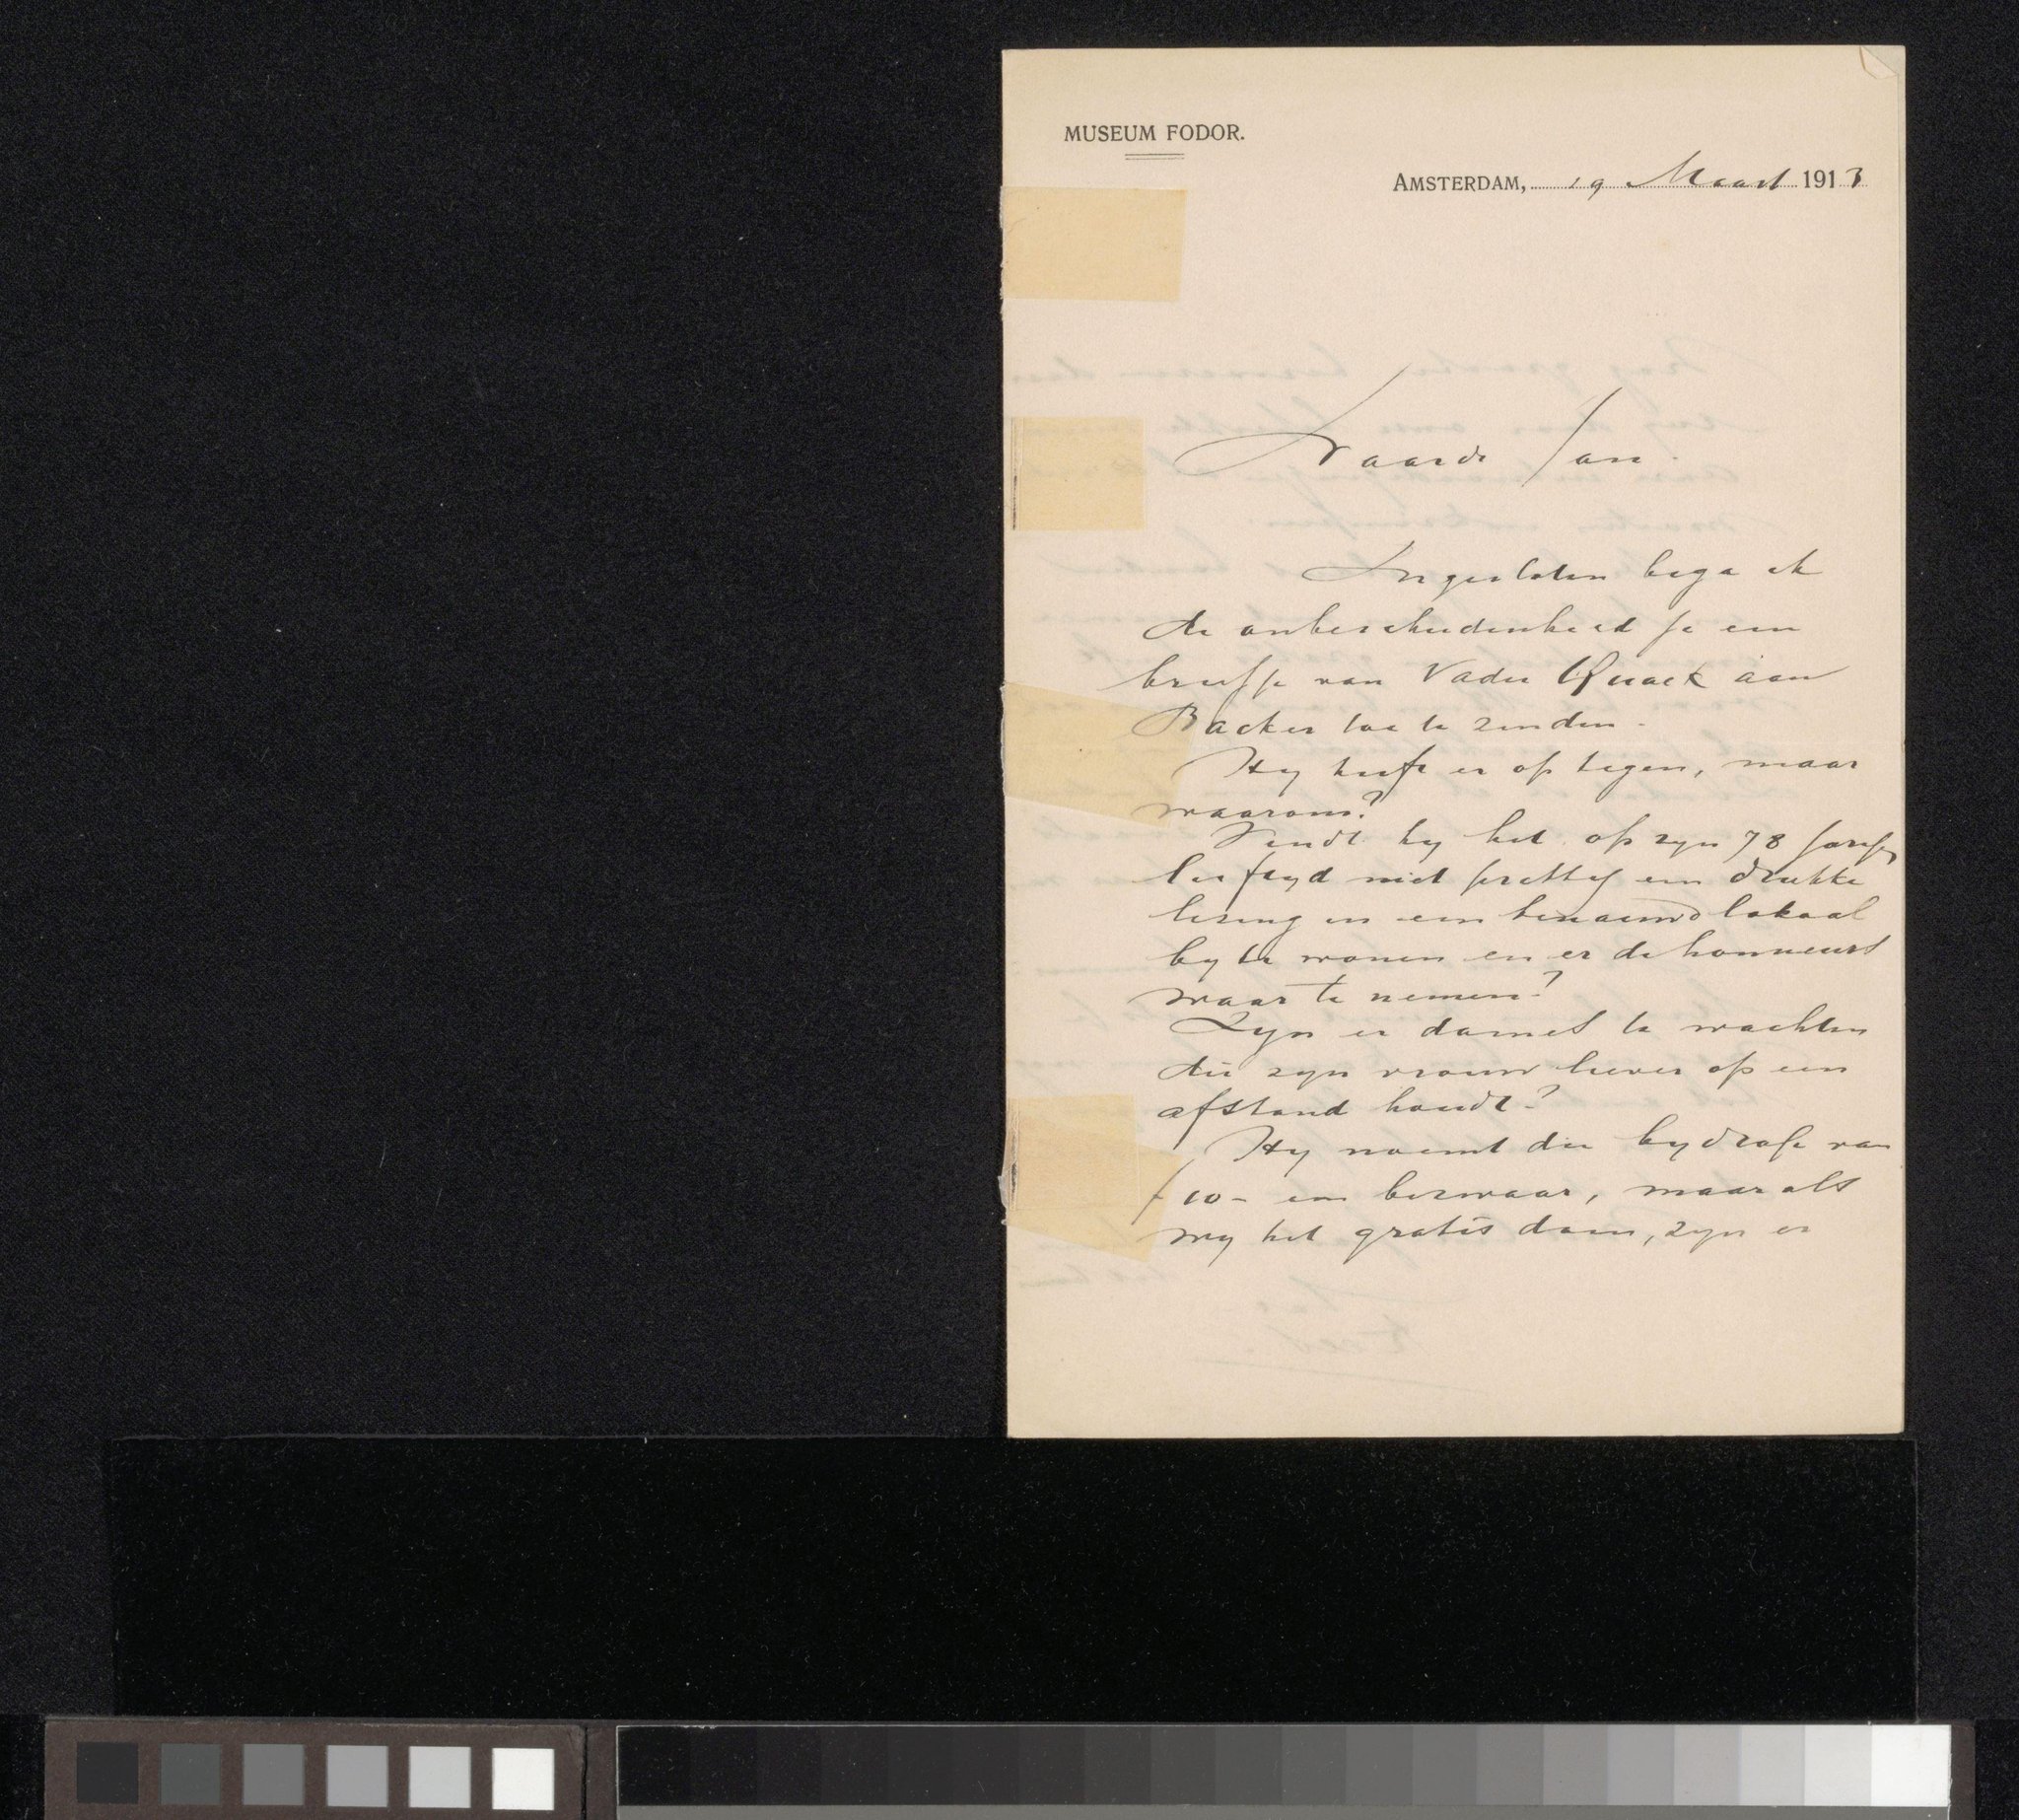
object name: letter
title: Brief aan Jan Veth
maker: cornelis gerardus t hooft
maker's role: draughtsman, painter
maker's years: 1866-1936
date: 1913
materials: ink, paper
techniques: pen, printing, writing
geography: amsterdam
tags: jan veth, hendrick peter godfried quack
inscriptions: collector's mark: ‘RPK’